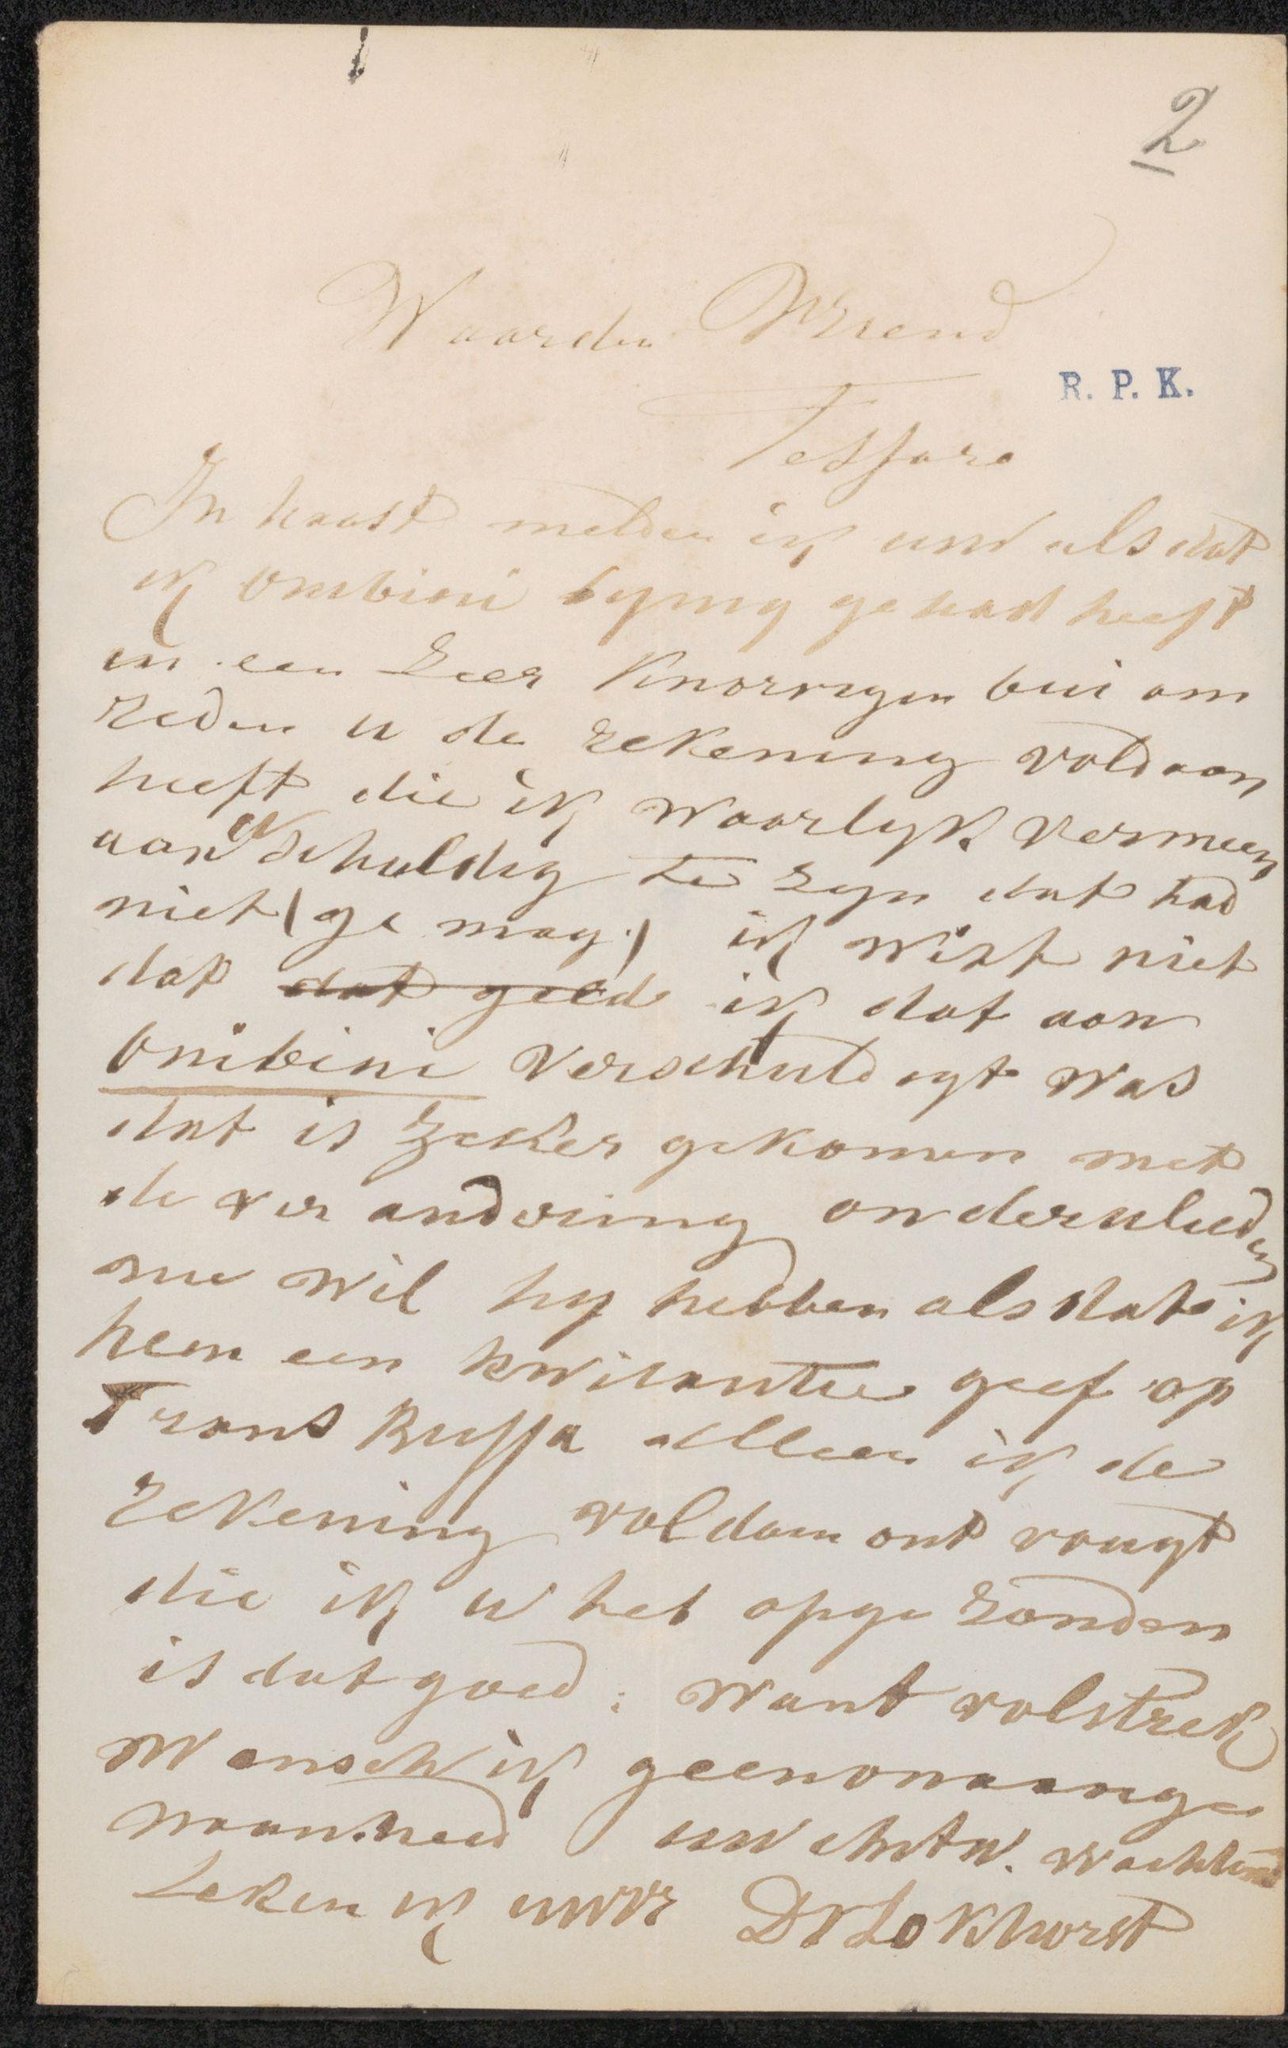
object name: letter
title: Brief aan Filippo Tessaro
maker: dirk van lokhorst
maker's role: draughtsman, painter, print maker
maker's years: 1818-1893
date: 1851-1893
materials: ink, paper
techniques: pen, writing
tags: amsterdam, money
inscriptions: collector's mark